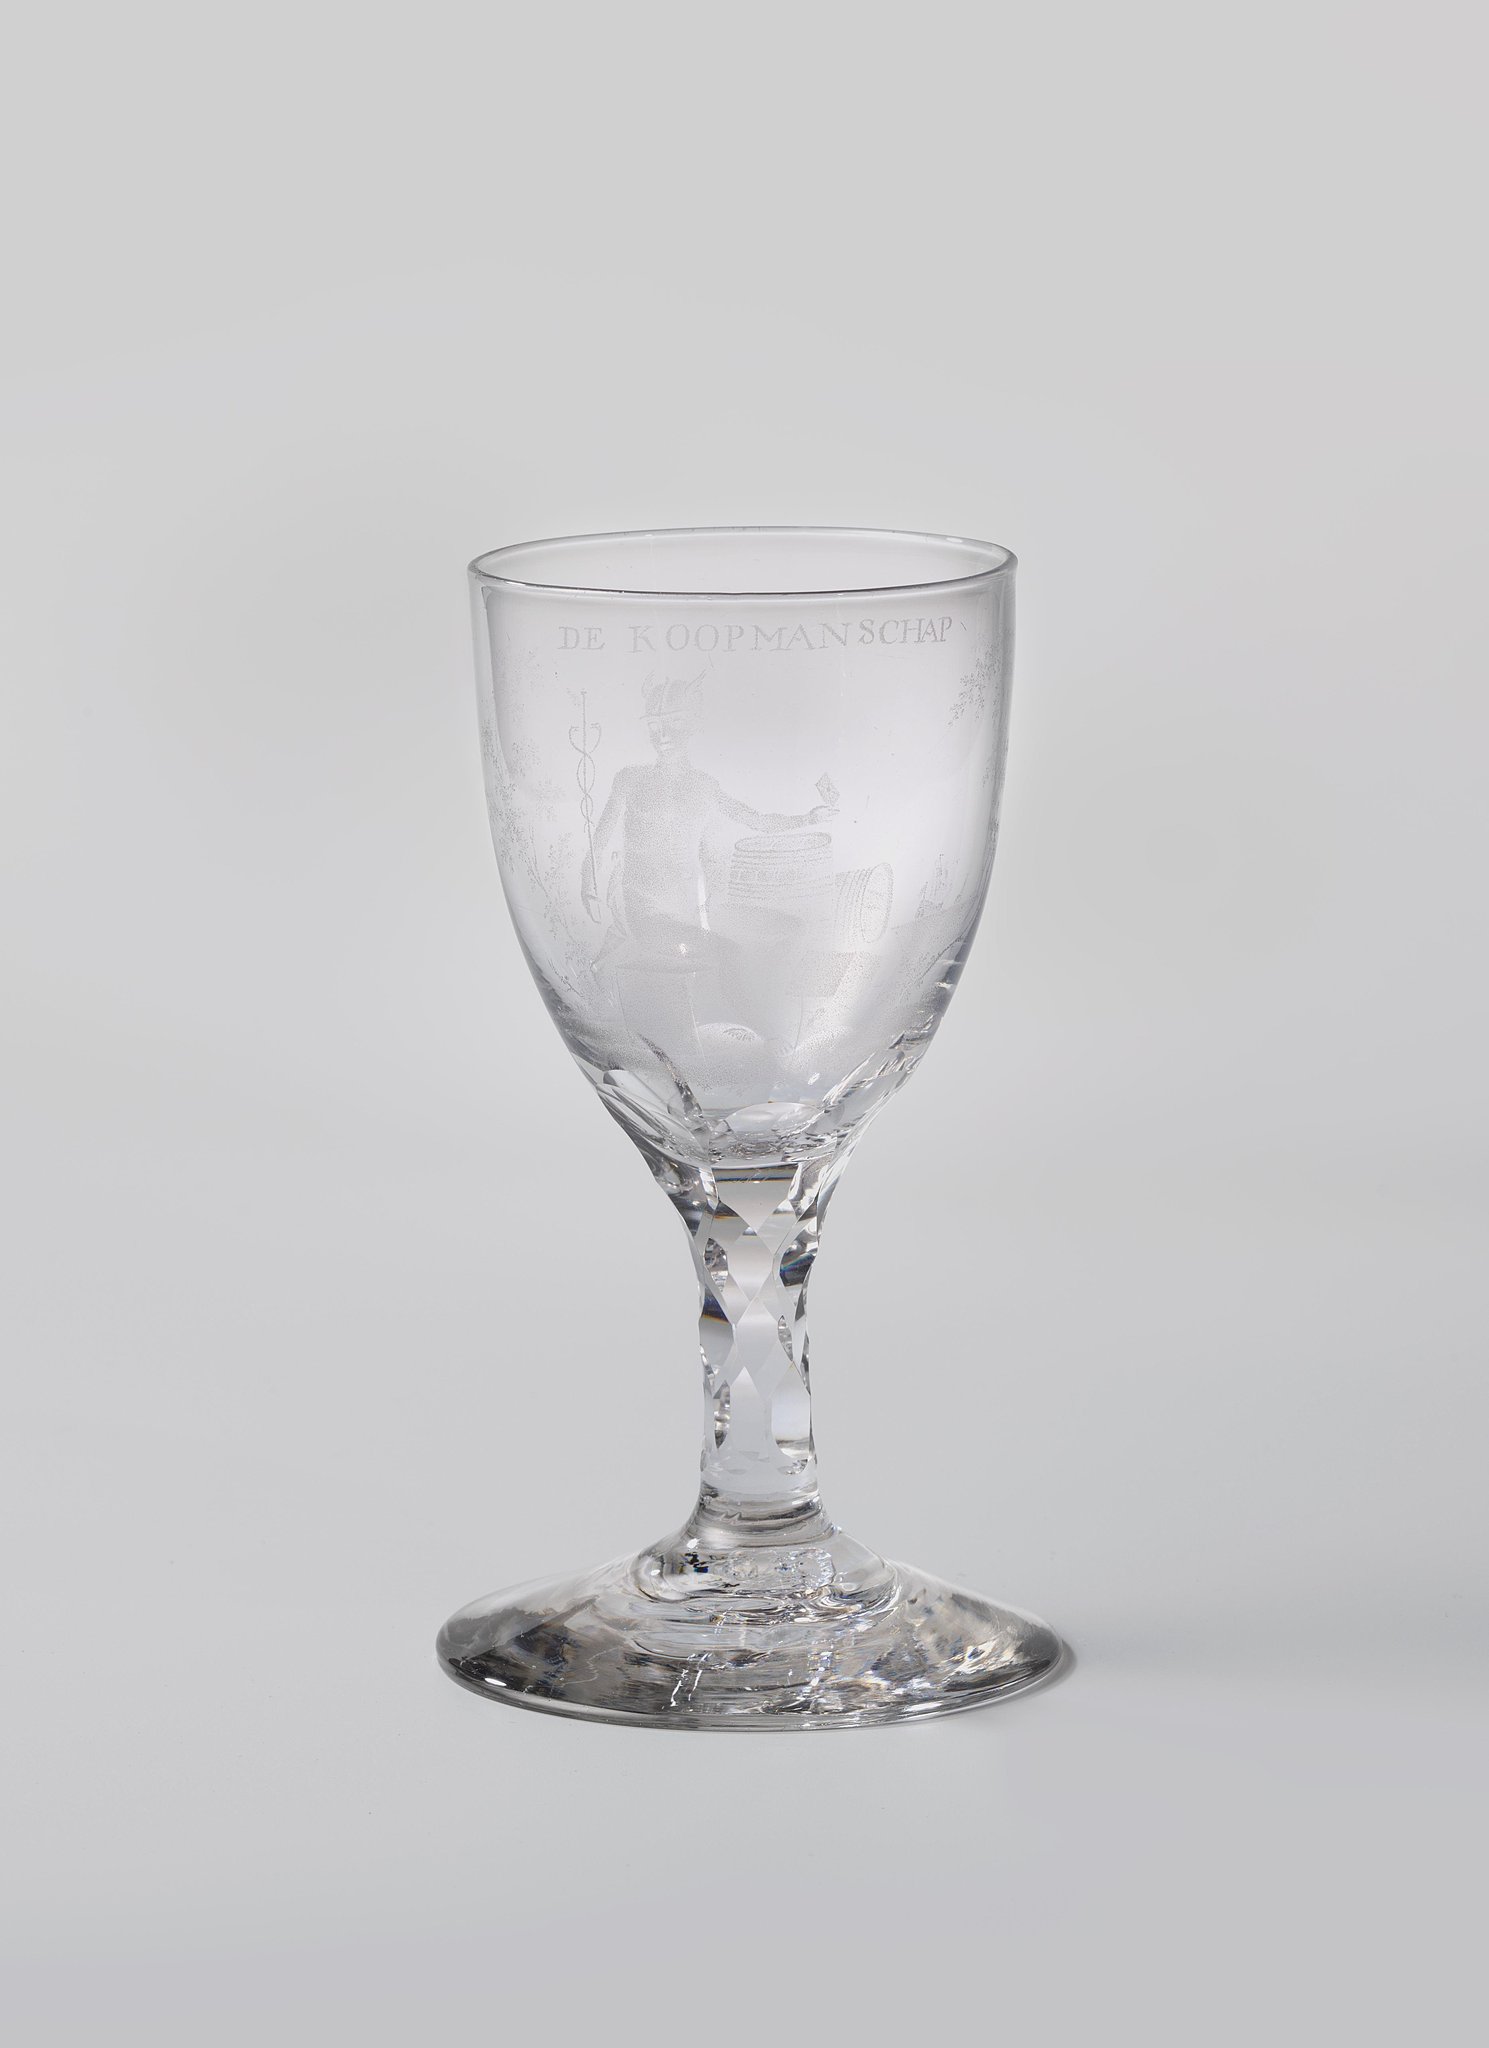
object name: goblet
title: Kelkglas met een voorstelling van het koopmanschap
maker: david wolff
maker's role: glasgraveur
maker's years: 1732-1798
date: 1775-1798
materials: glass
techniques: glassblowing, grinding, engraving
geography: northern netherlands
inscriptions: inscription: ‘J: G: Smeyser’, inscription: ‘DE KOOPMANSCHAP’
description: Mercury, God of Trade, c. 1775 - 1798